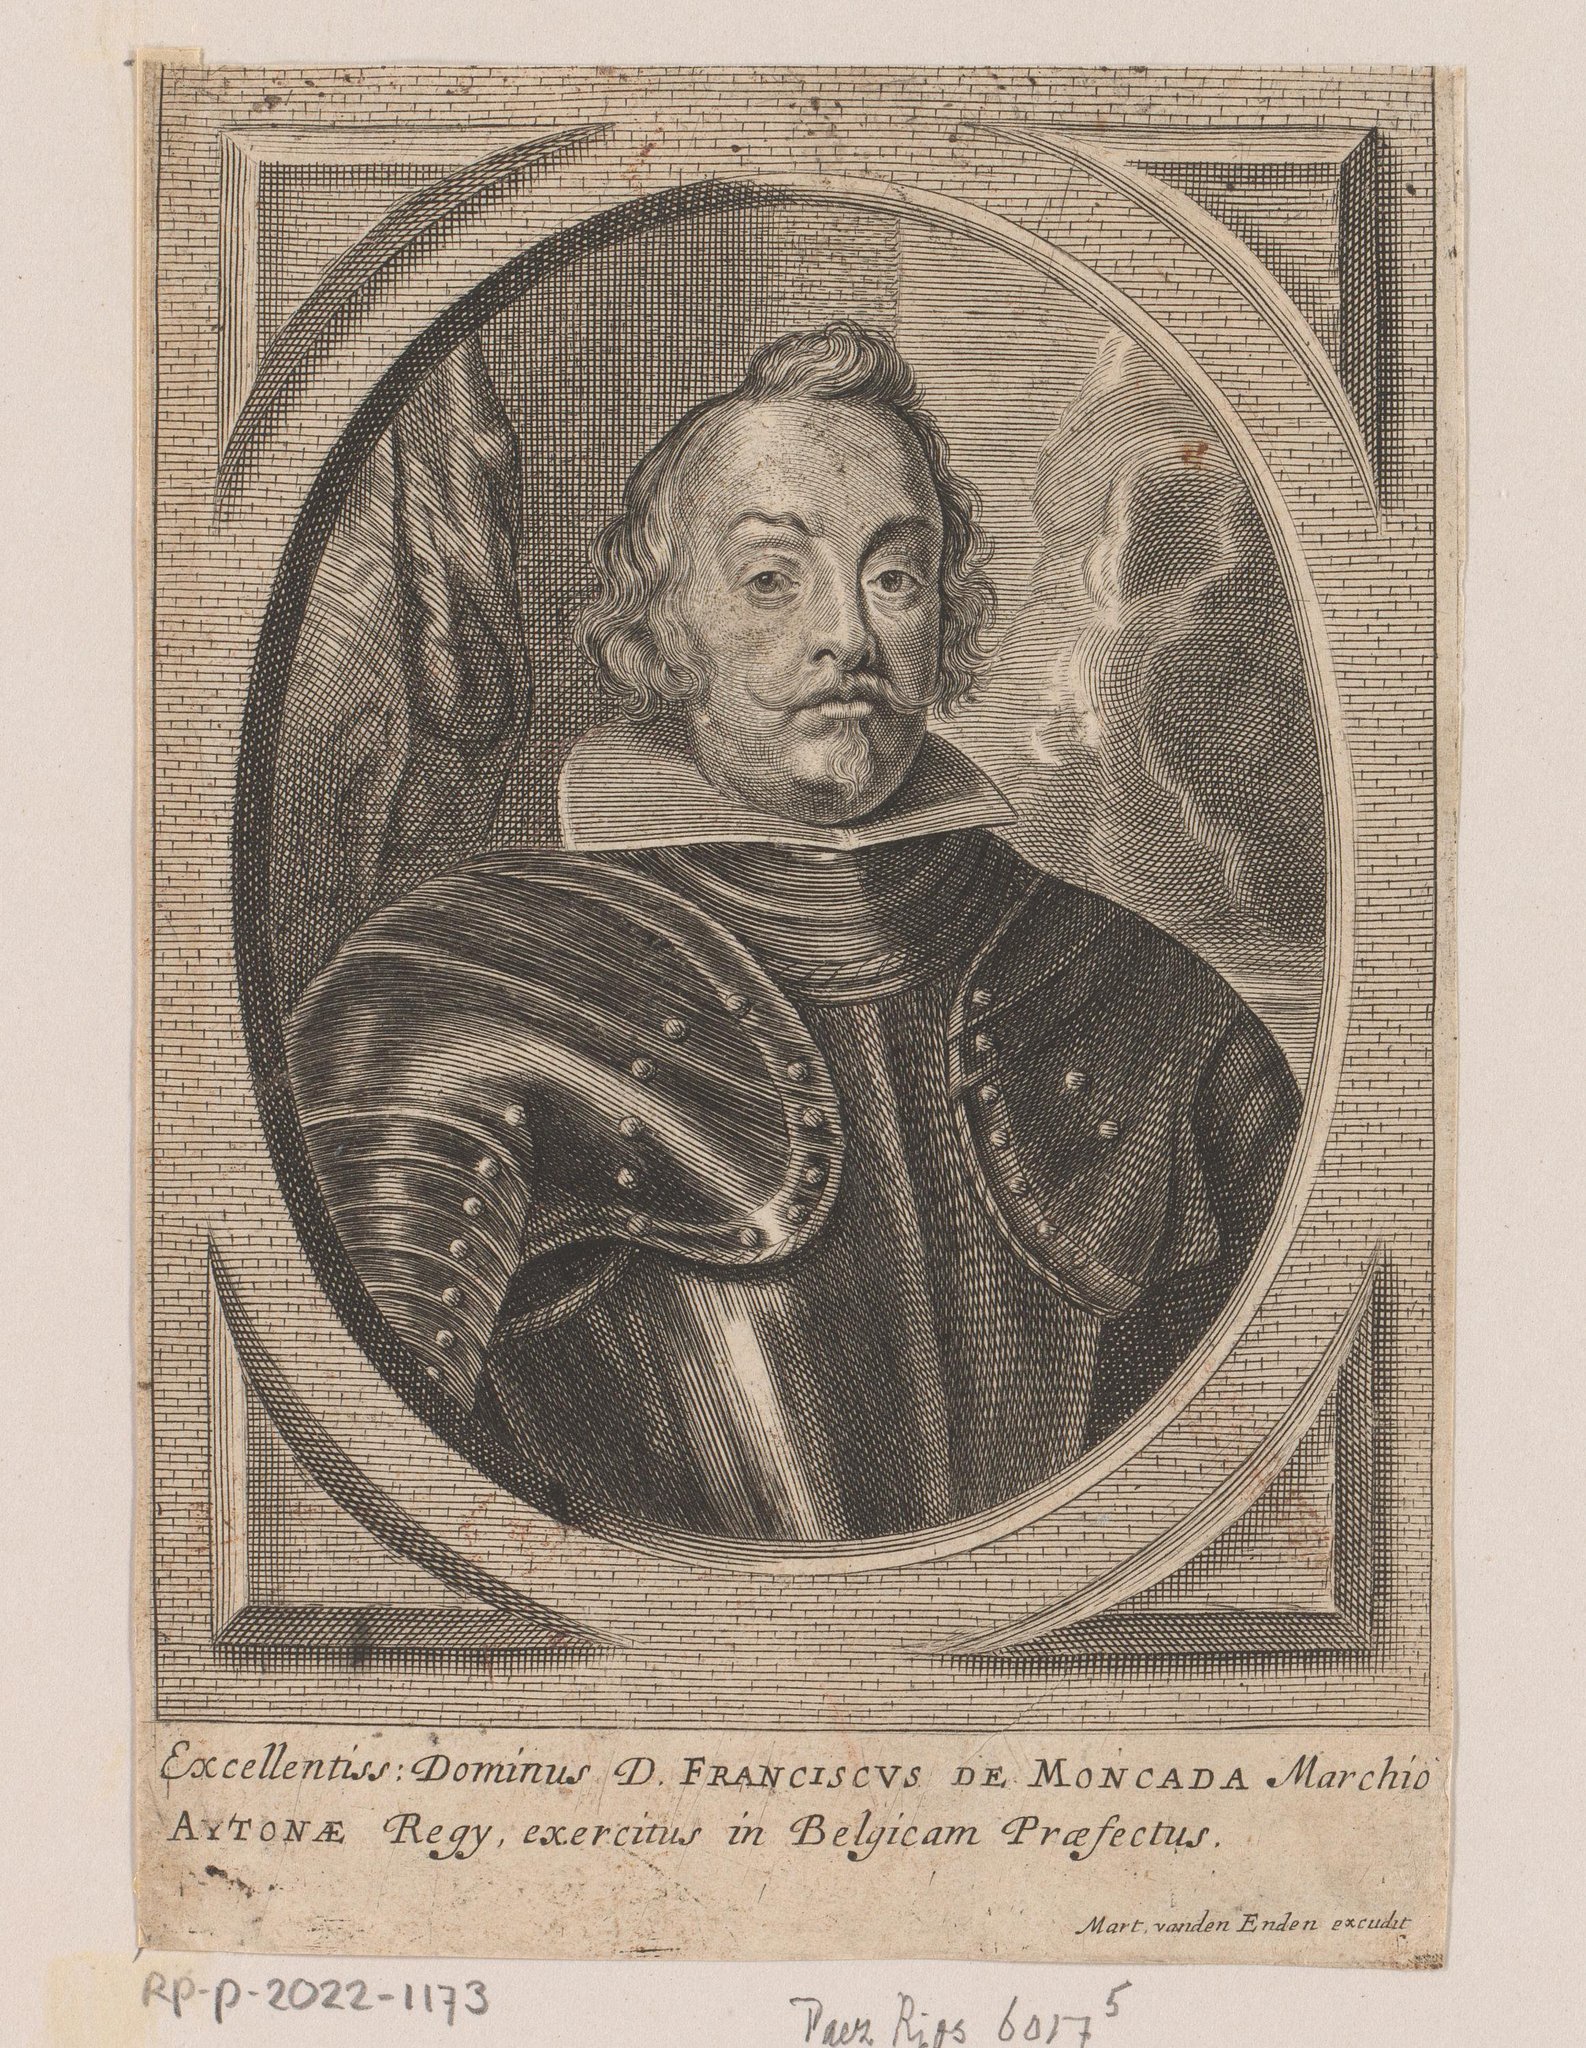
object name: print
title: Portret van Francisco de Moncada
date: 1630-1654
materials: paper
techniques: engraving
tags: brussels, francisco de moncada (markies van aytona), armour, historical persons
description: Met tweeregelig onderschrift in het Latijn.